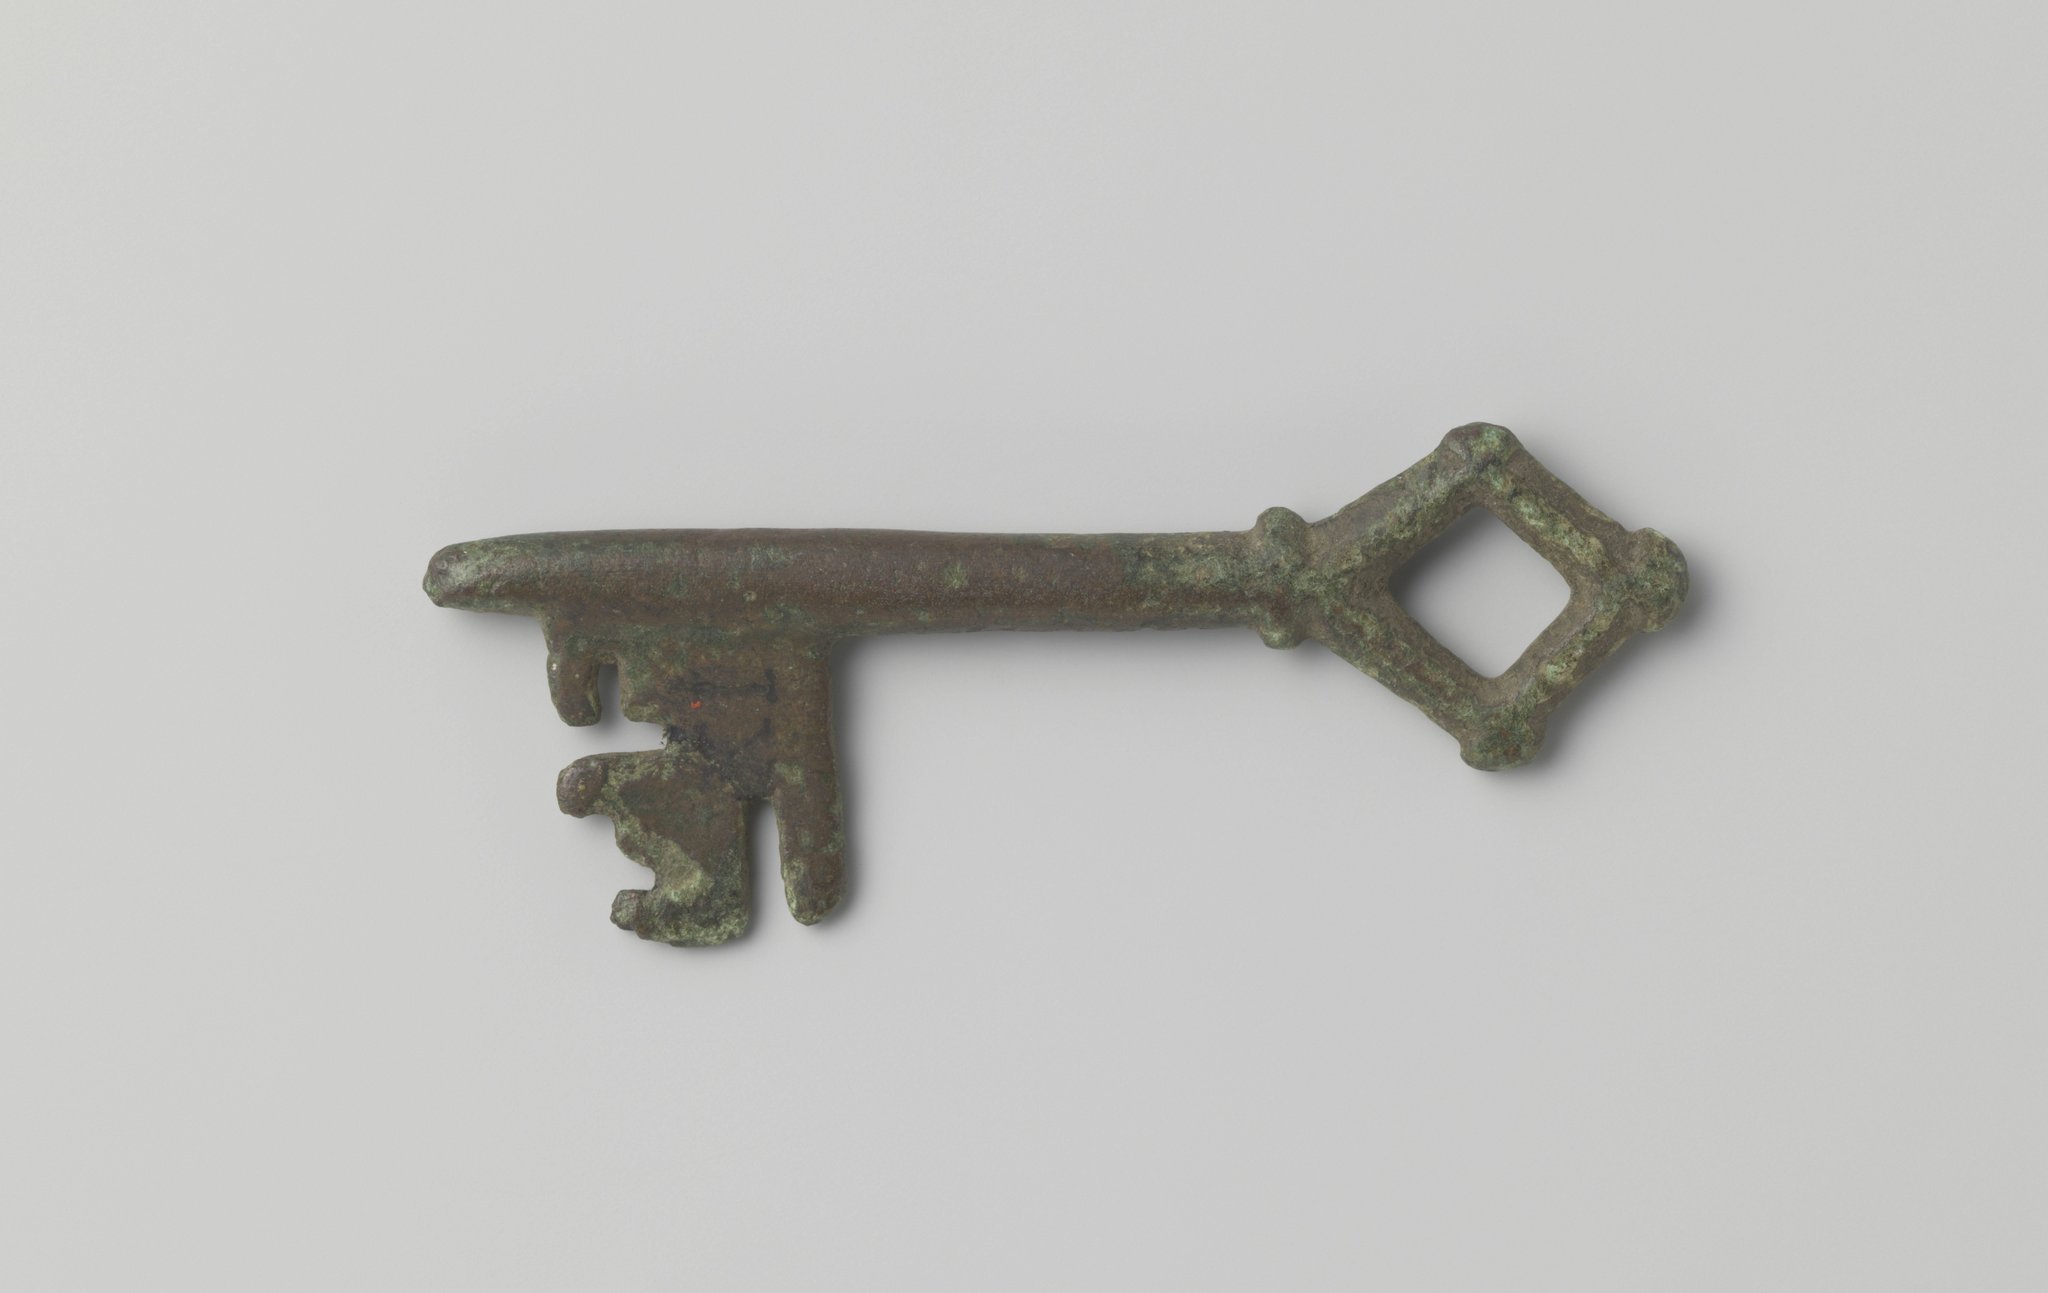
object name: socket wrench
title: Dopsleutel van brons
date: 1300-1400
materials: bronze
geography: france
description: Bronzen dopsleutel, ruitvormige ring, pen uitlopende in spitse punt, baard van onderen en van voren ingesneden.